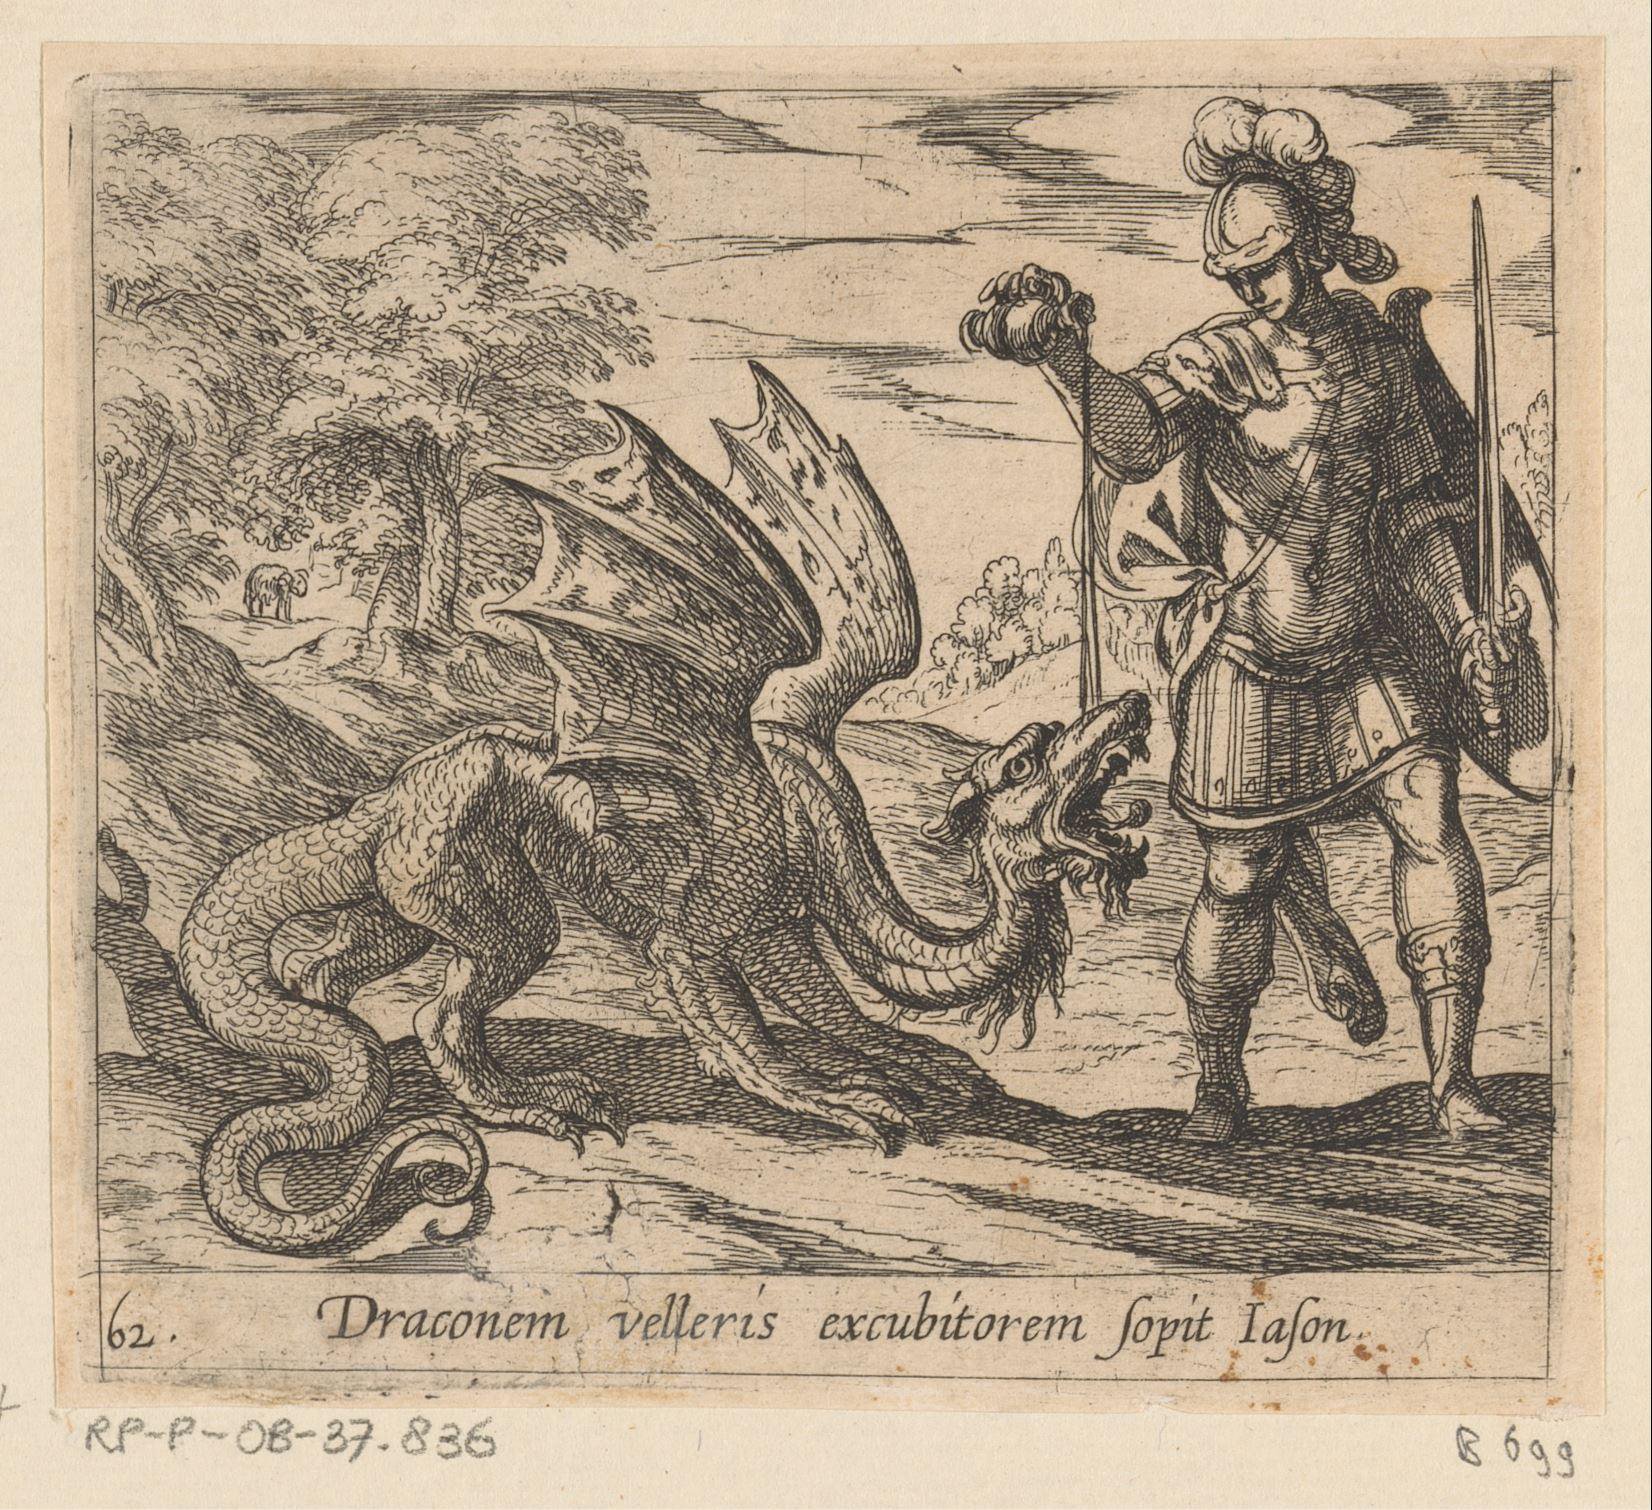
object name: print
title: Metamorfosen van Ovidius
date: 1606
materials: paper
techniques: etching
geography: antwerp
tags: fight with the dragon; jason sprinkles a drug in its eyes, possibly assisted by medea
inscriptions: collector's mark: Lugt 240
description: Jason giet een middeltje in de ogen van de draak. Door het middeltje valt de draak in slaap. Titel in het Latijn in ondermarge.